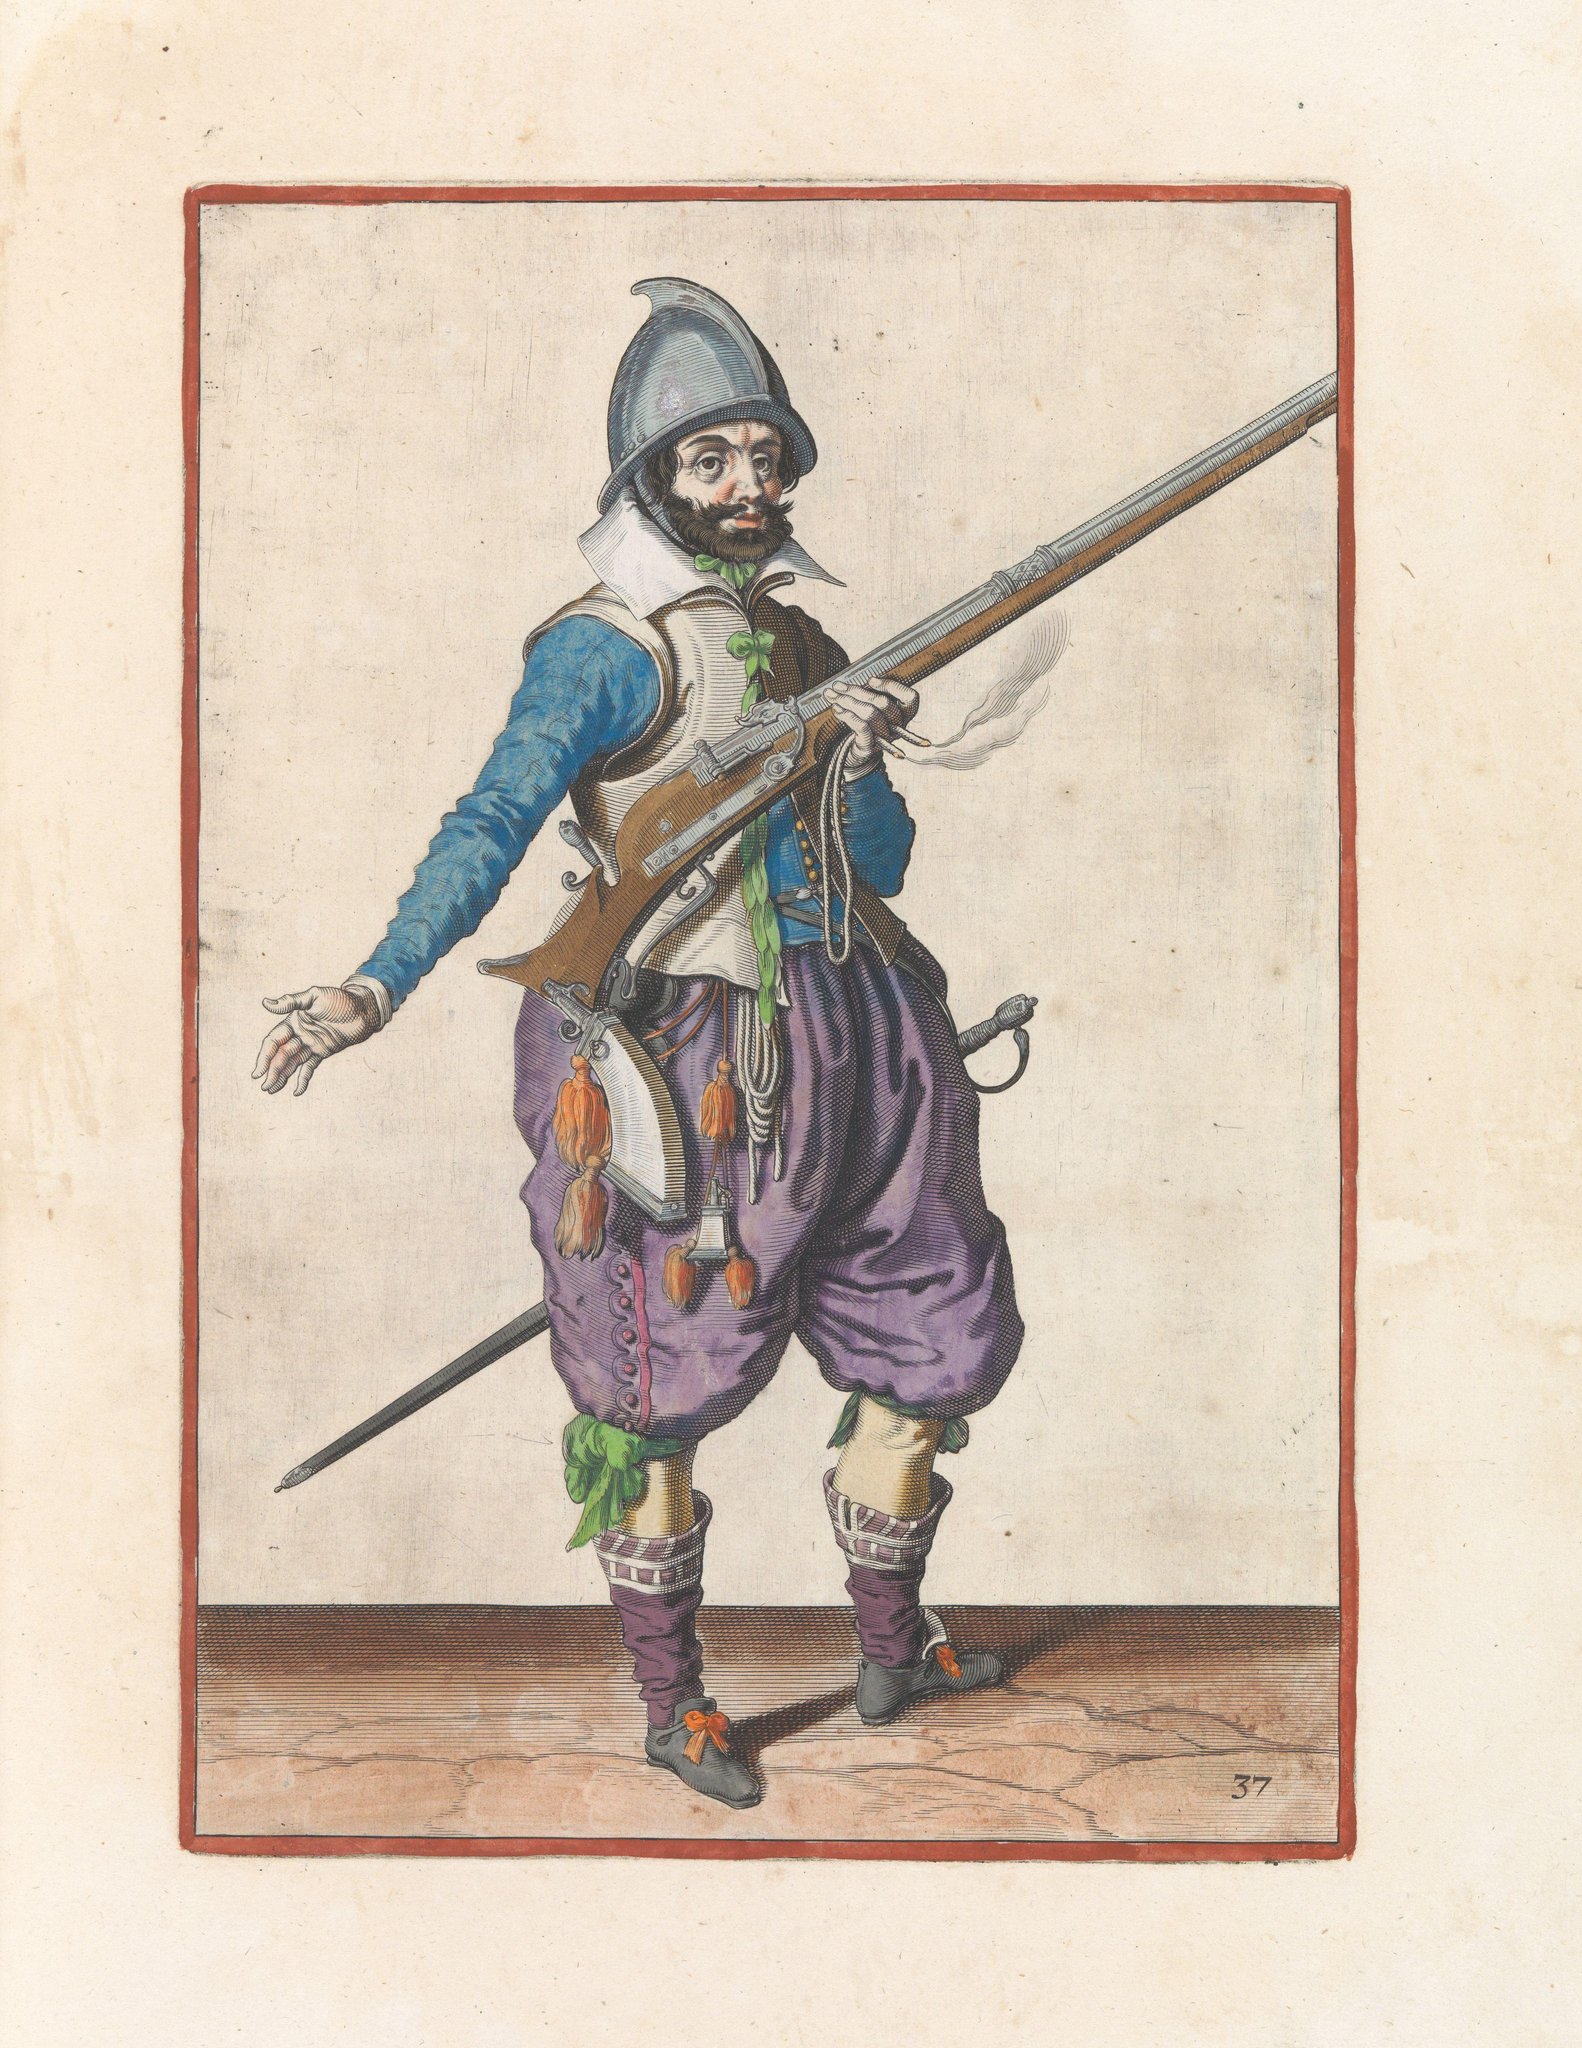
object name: print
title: Corte onderwysinghe op de figuerliicke afbeeldinghe, belanghende t'rechte ghebruyck des Roers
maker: jacques de gheyn (ii)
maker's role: painter, print maker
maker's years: 1565-1629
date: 1597-1607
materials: paper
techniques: engraving, hand coloring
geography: the hague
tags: handling of weapons ~ military training, firearms: rifle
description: Een soldaat op wacht, ten voeten uit, naar rechts, die een roer (een bepaald type vuurwapen) met zijn linkerhand bij zijn rechterzijde vasthoudt, de loop schuin omhoog gericht. In zijn linkerhand behalve het roer ook een brandende lont. Zijn rechterhand steekt hij uit. Deze prent is onderdeel van de reeks van 42 met de hand genummerde prenten van roerschutters in de Wapenhandelinghe. Op dit is exemplaar het nummer gedrukt.